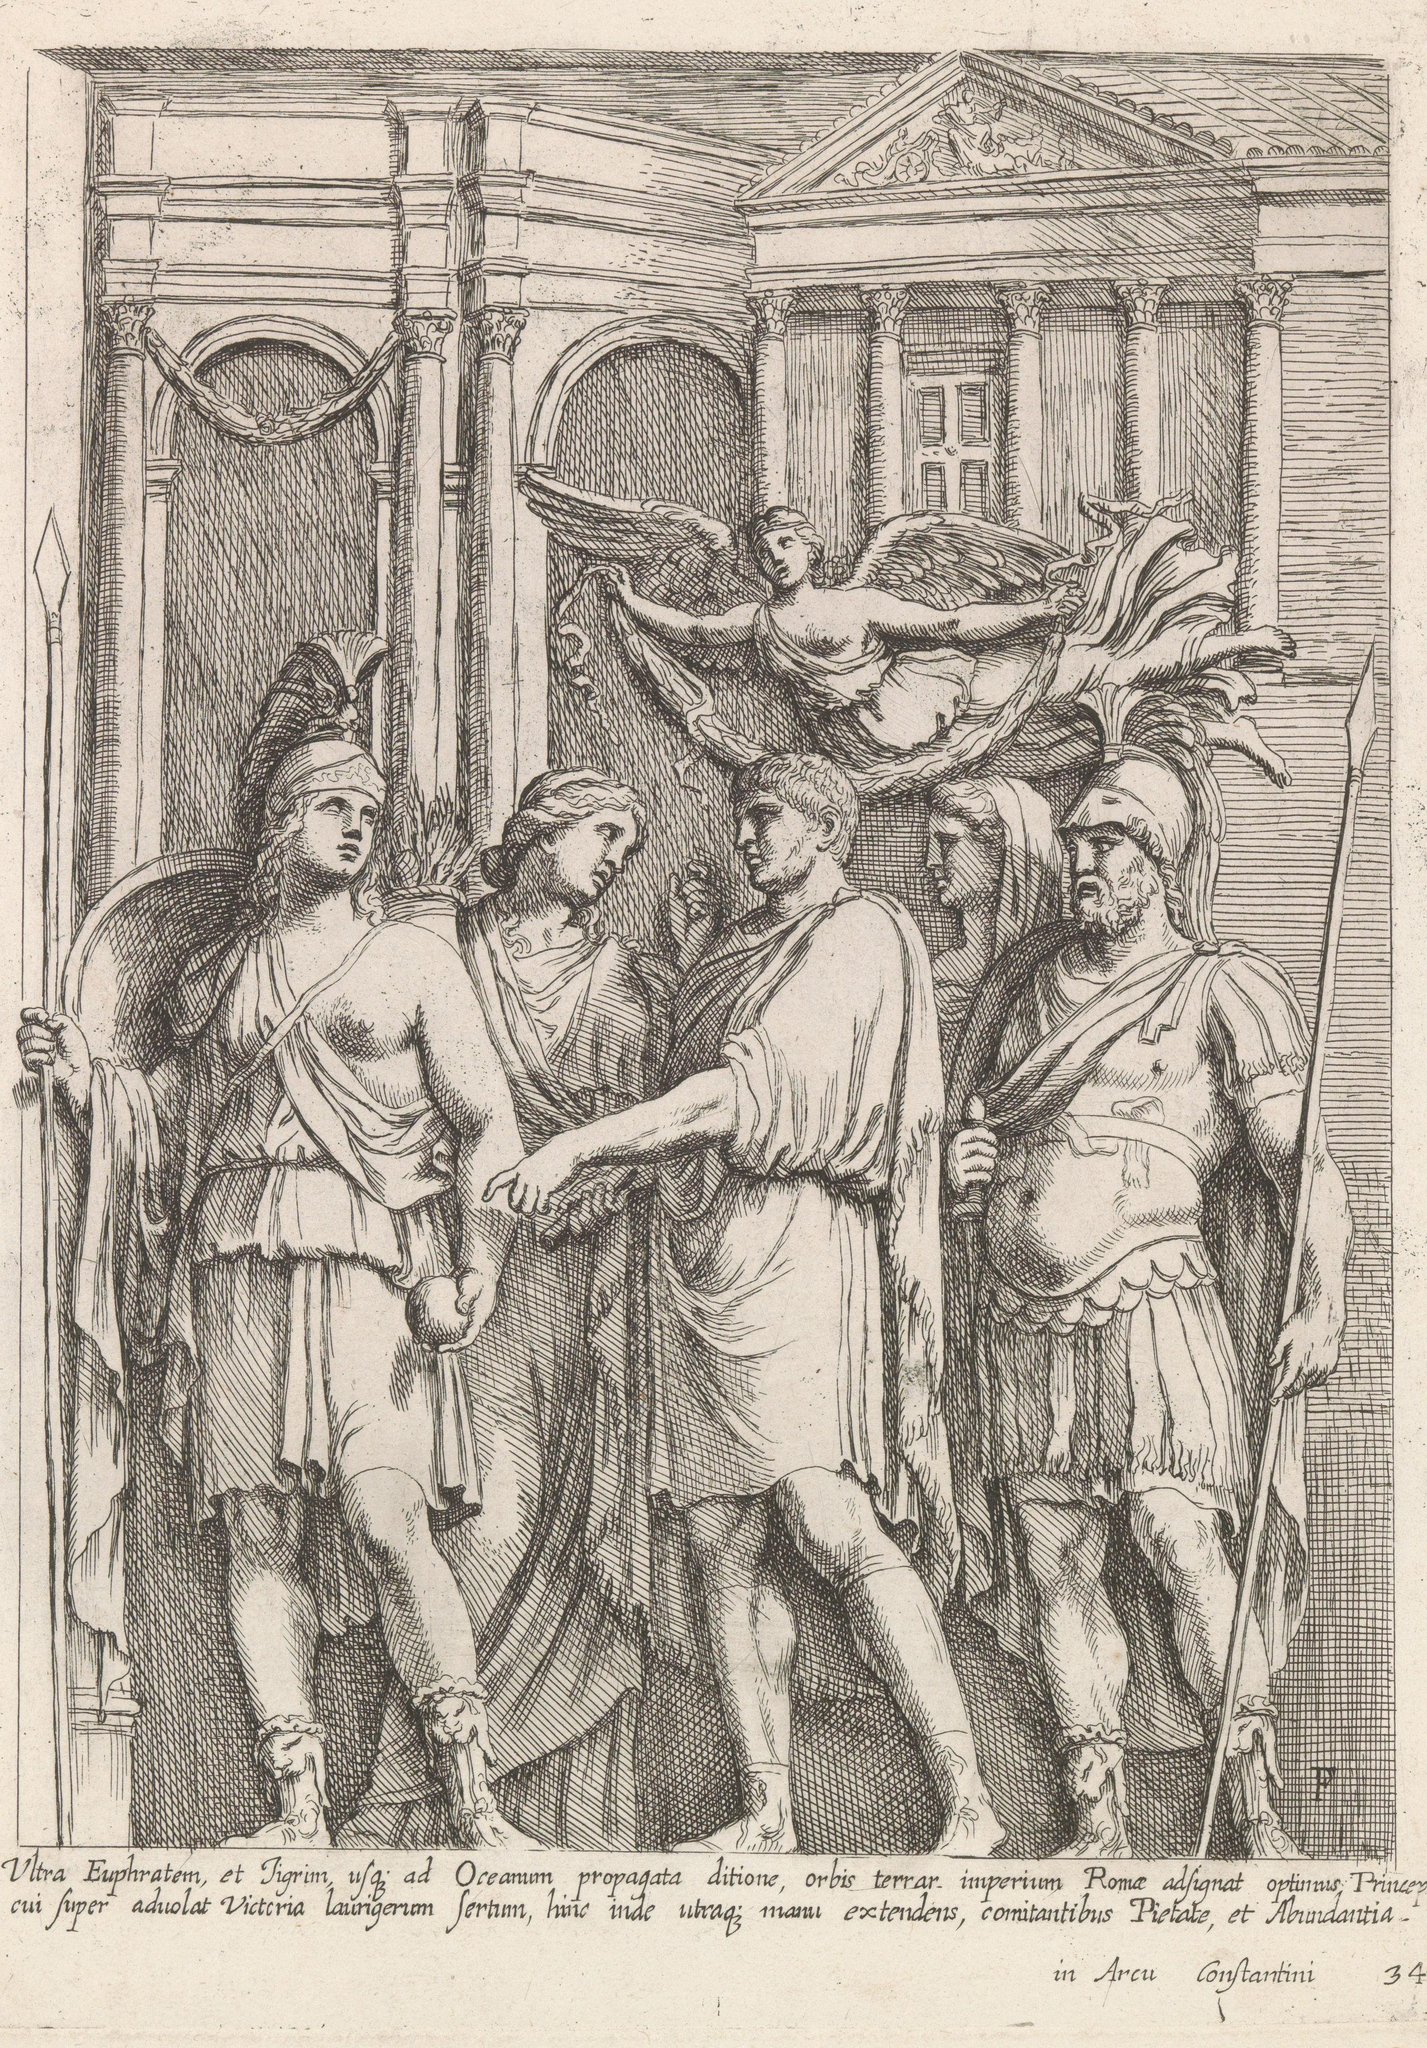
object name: album leaf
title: Reliëf met een intocht van een Romeinse keizer in Rome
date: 1645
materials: paper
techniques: etching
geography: paris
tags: (story of) mars (ares), 'victoria'; 'vittoria', 'vittoria navale', 'vittoria degl'antichi' (ripa), piece of sculpture, reproduction of a piece of sculpture, ruler, sovereign, rome, arch of constantine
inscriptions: number: ‘61’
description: Deze prent maakt deel uit van een reeks van 54 prenten (+ titelprent) naar antieke reliëfs. De nummering op de prenten loopt van 1 tot en met 50. Sommige prenten hebben dubbele nummers. Naar de reliëfs op de Boog van Constantijn te Rome.